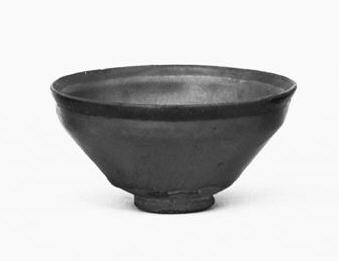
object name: teabowl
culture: chinese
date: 960-1279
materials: fur, glaze, stoneware